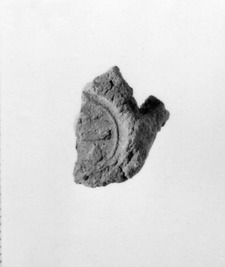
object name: sealing, nebmaatre, amenhotep iii, horus, re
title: Document Sealing With the Throne Name of Amenhotep III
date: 1390-1352 BCE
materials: mud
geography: egypt